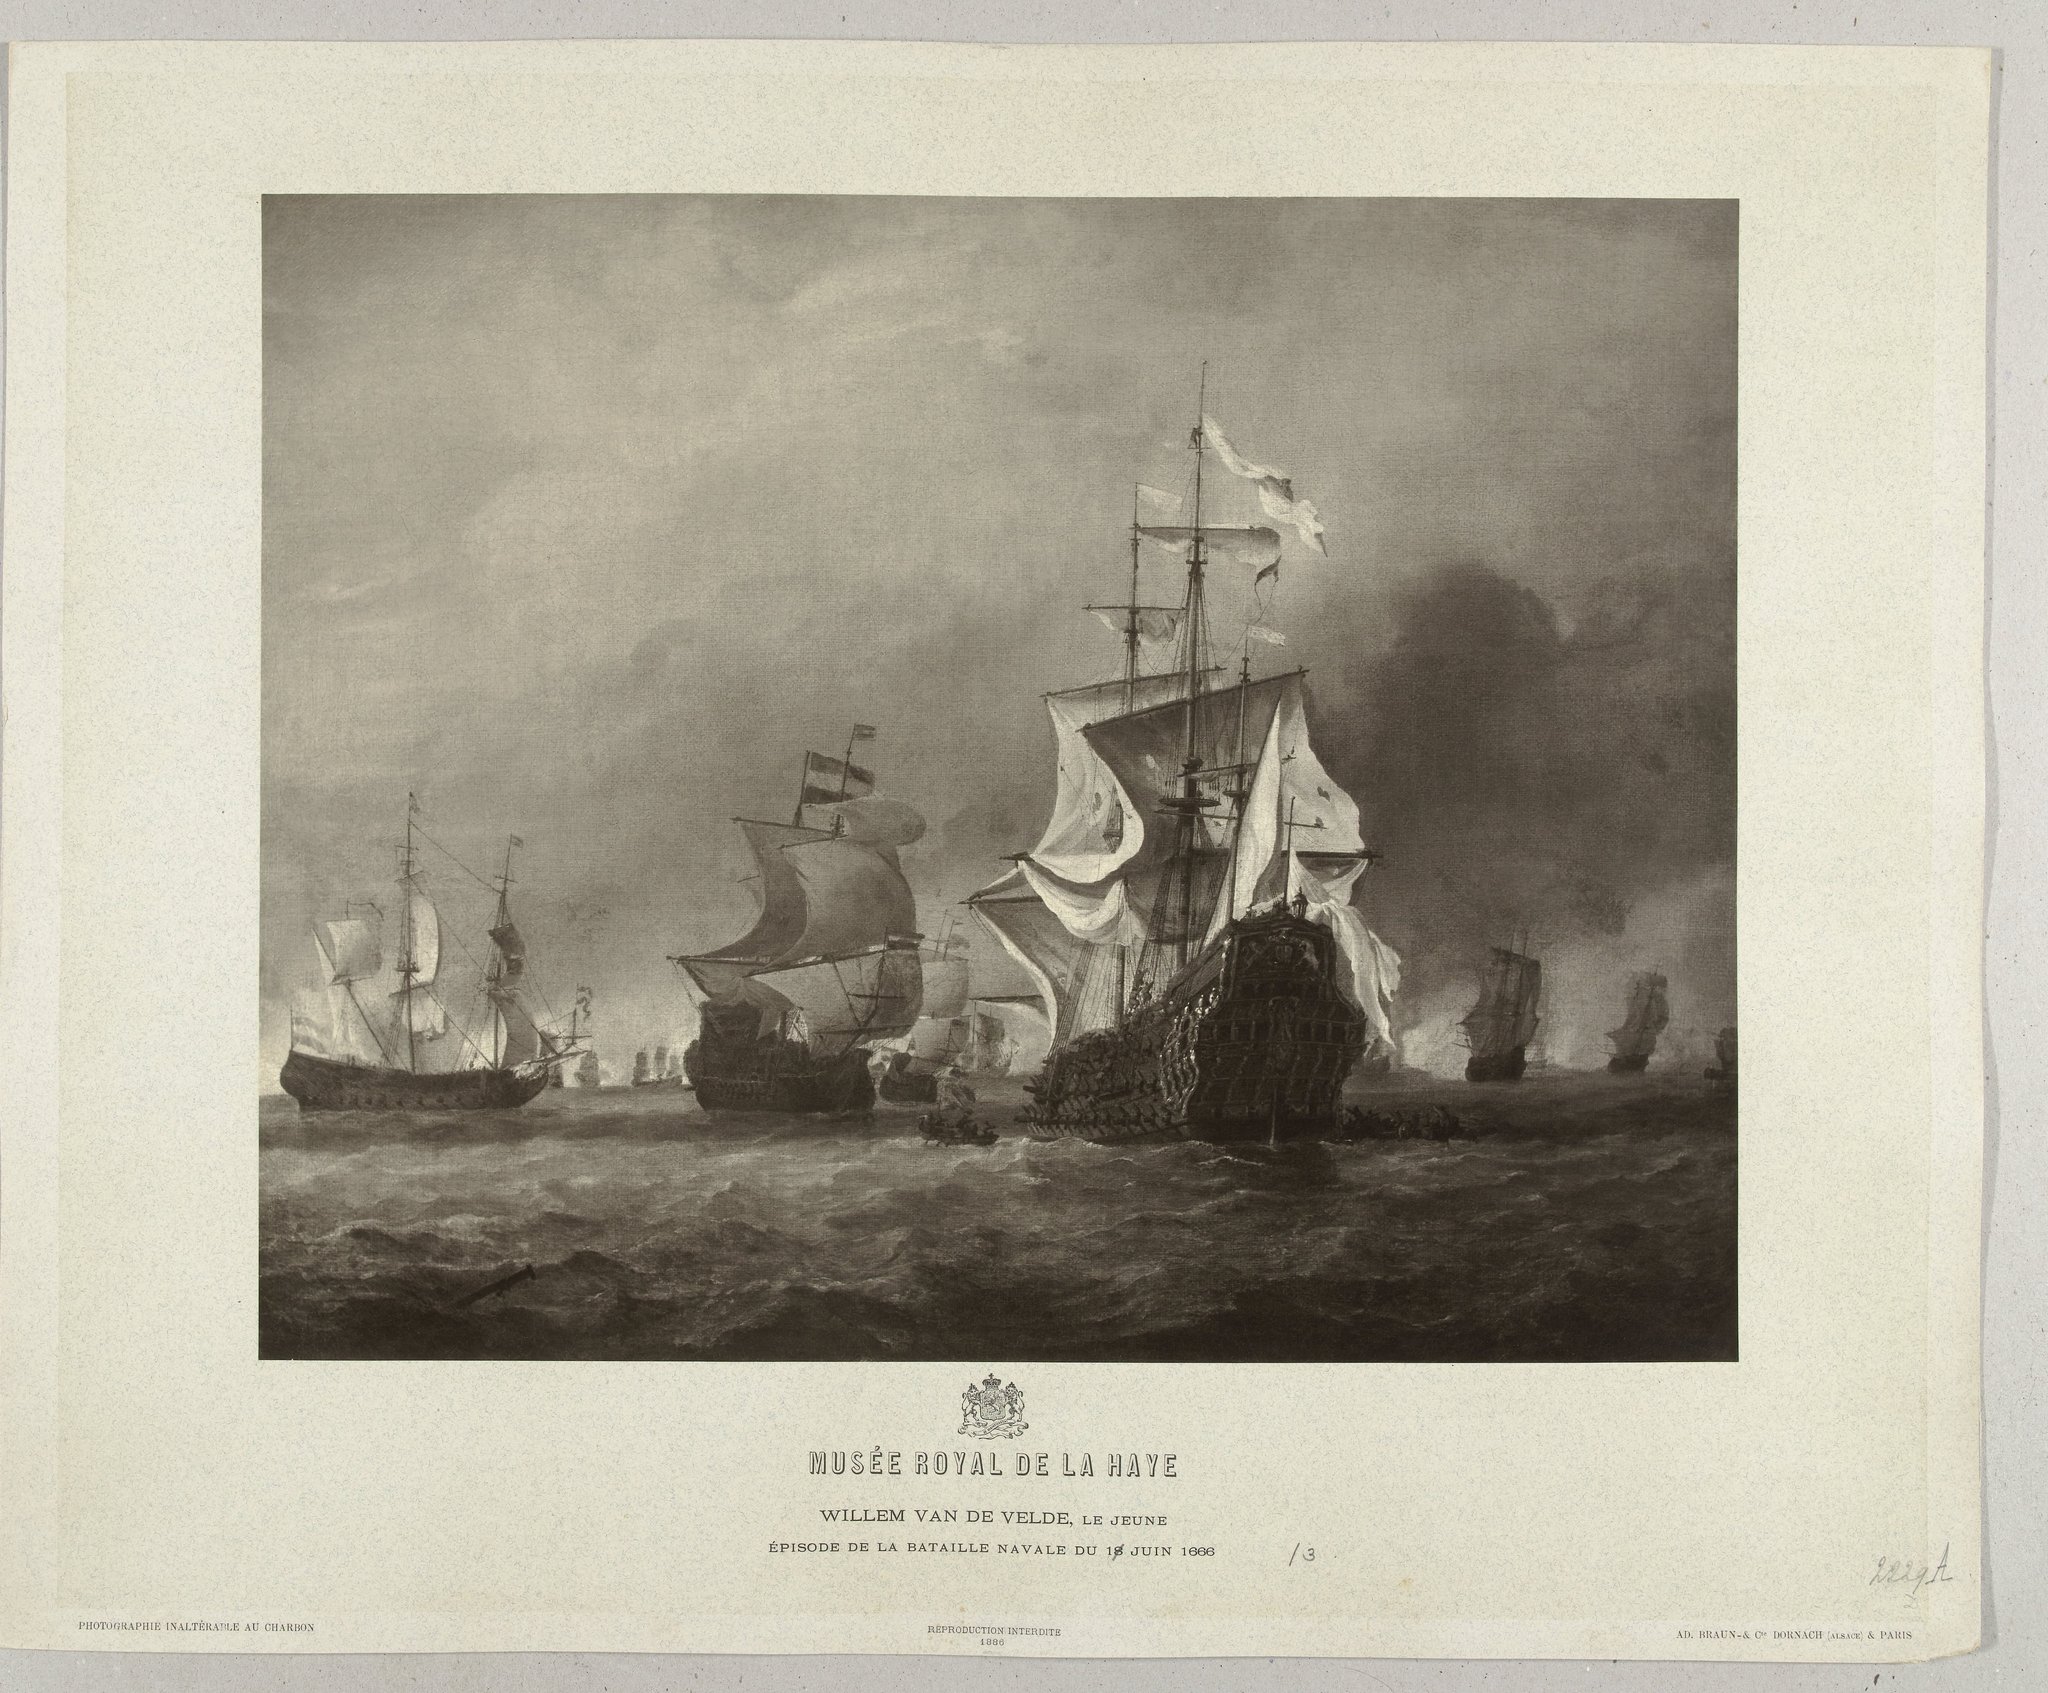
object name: historical object representation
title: Episode de la bataille navale du 18 Juin 1666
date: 1886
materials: cardboard, paper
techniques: carbon print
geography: paris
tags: battle (+ naval force)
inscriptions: date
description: Foto-reproductie van het schilderij van de verovering van het Engelse schip de Royal Prince op 13 juni 1666, tijdens de Vierdaagse Zeeslag tussen de Staatse vloot onder admiraal Michiel de Ruyter en de Engelse vloot onder admiraal George Monck, 11-14 juni 1666. Naar het schilderij van Willem van de Velde de Jonge in de collectie van het Mauritshuis te Den Haag.